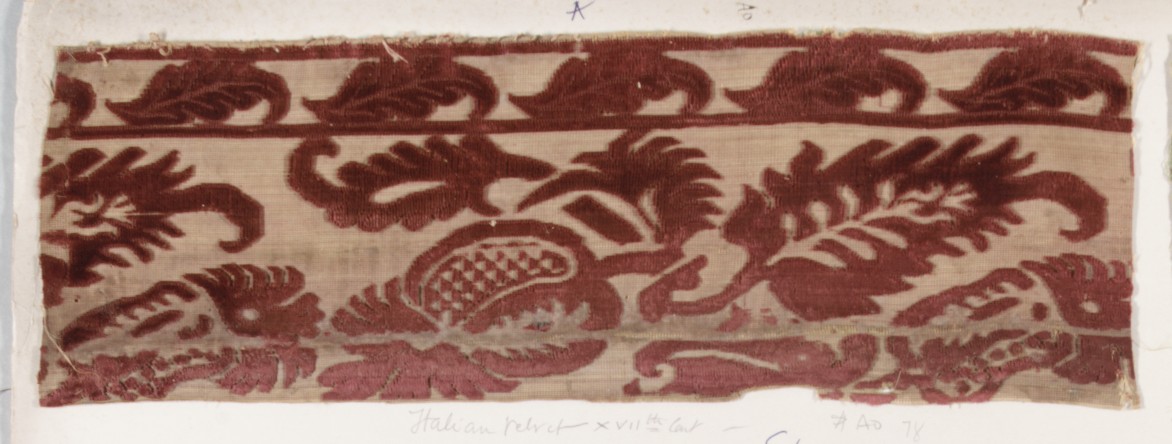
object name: fragment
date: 1501-1700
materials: silk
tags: leaves